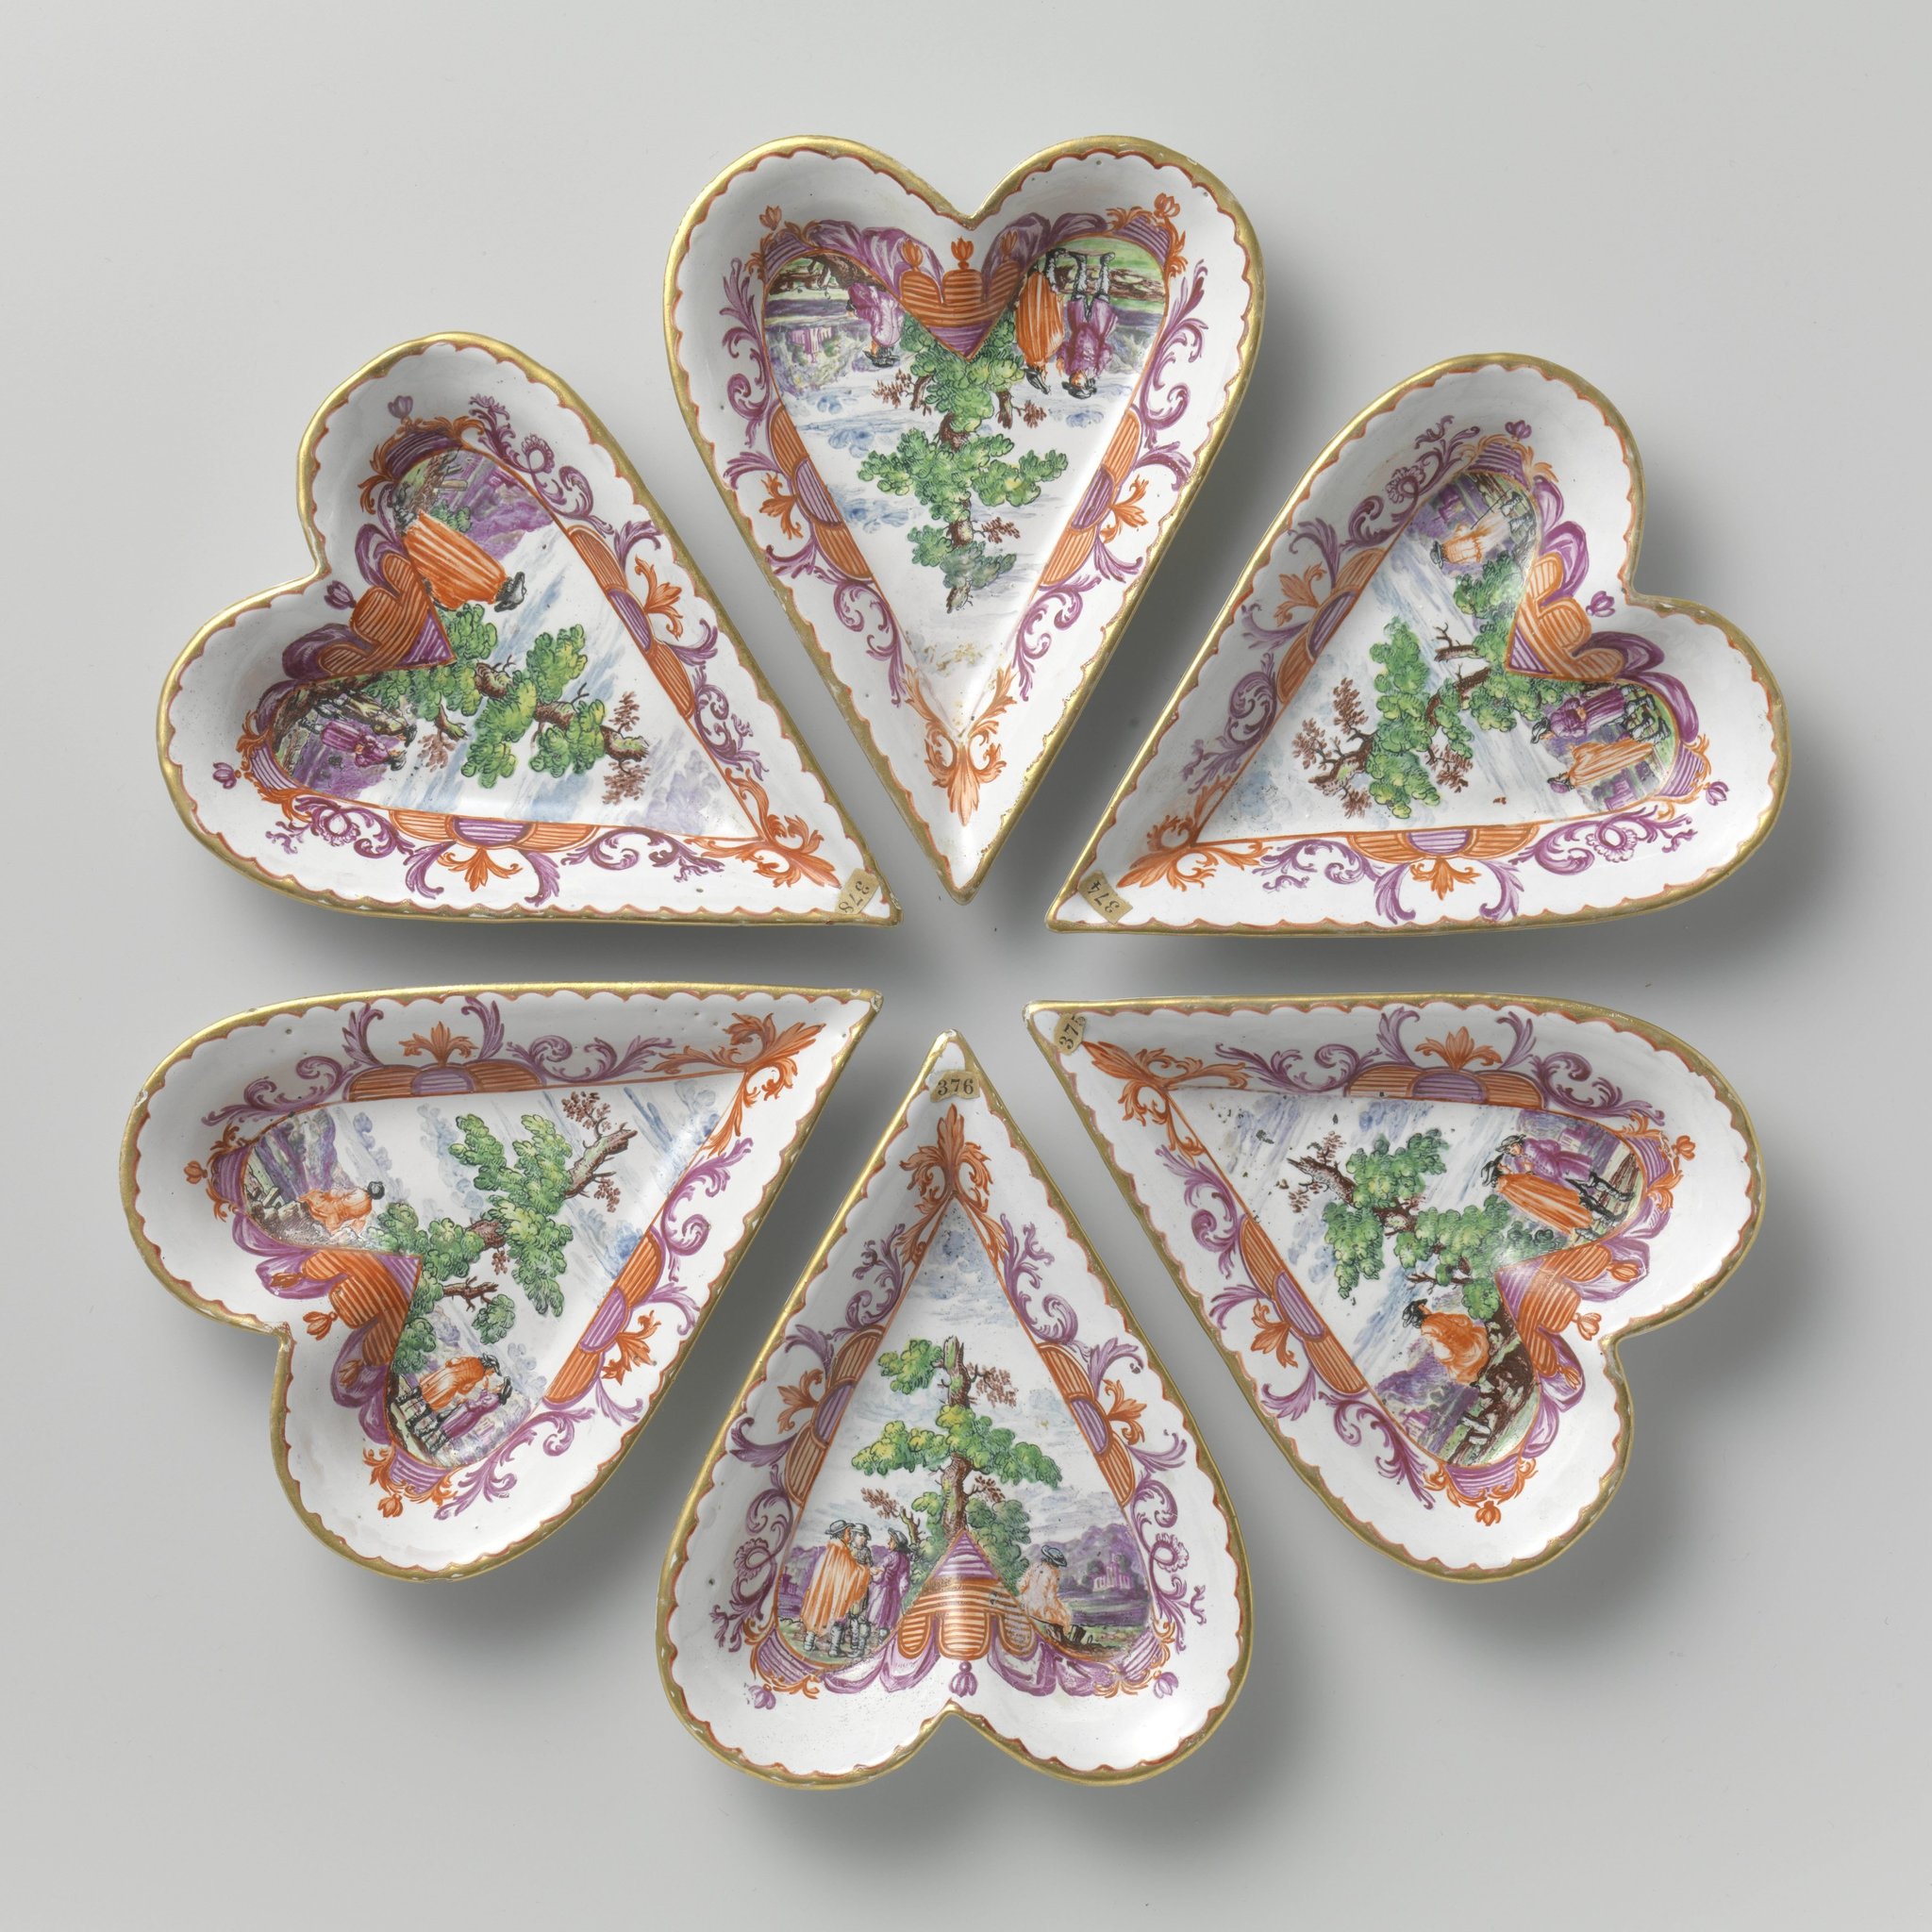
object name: dish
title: Set of six small heart-shaped dishes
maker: Anonymous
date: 1735-1755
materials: earthenware, glaze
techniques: kiln, painted, polychromy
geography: delft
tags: trees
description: Delft, c. 1735–1755 tin-glazed earthenware (faience)